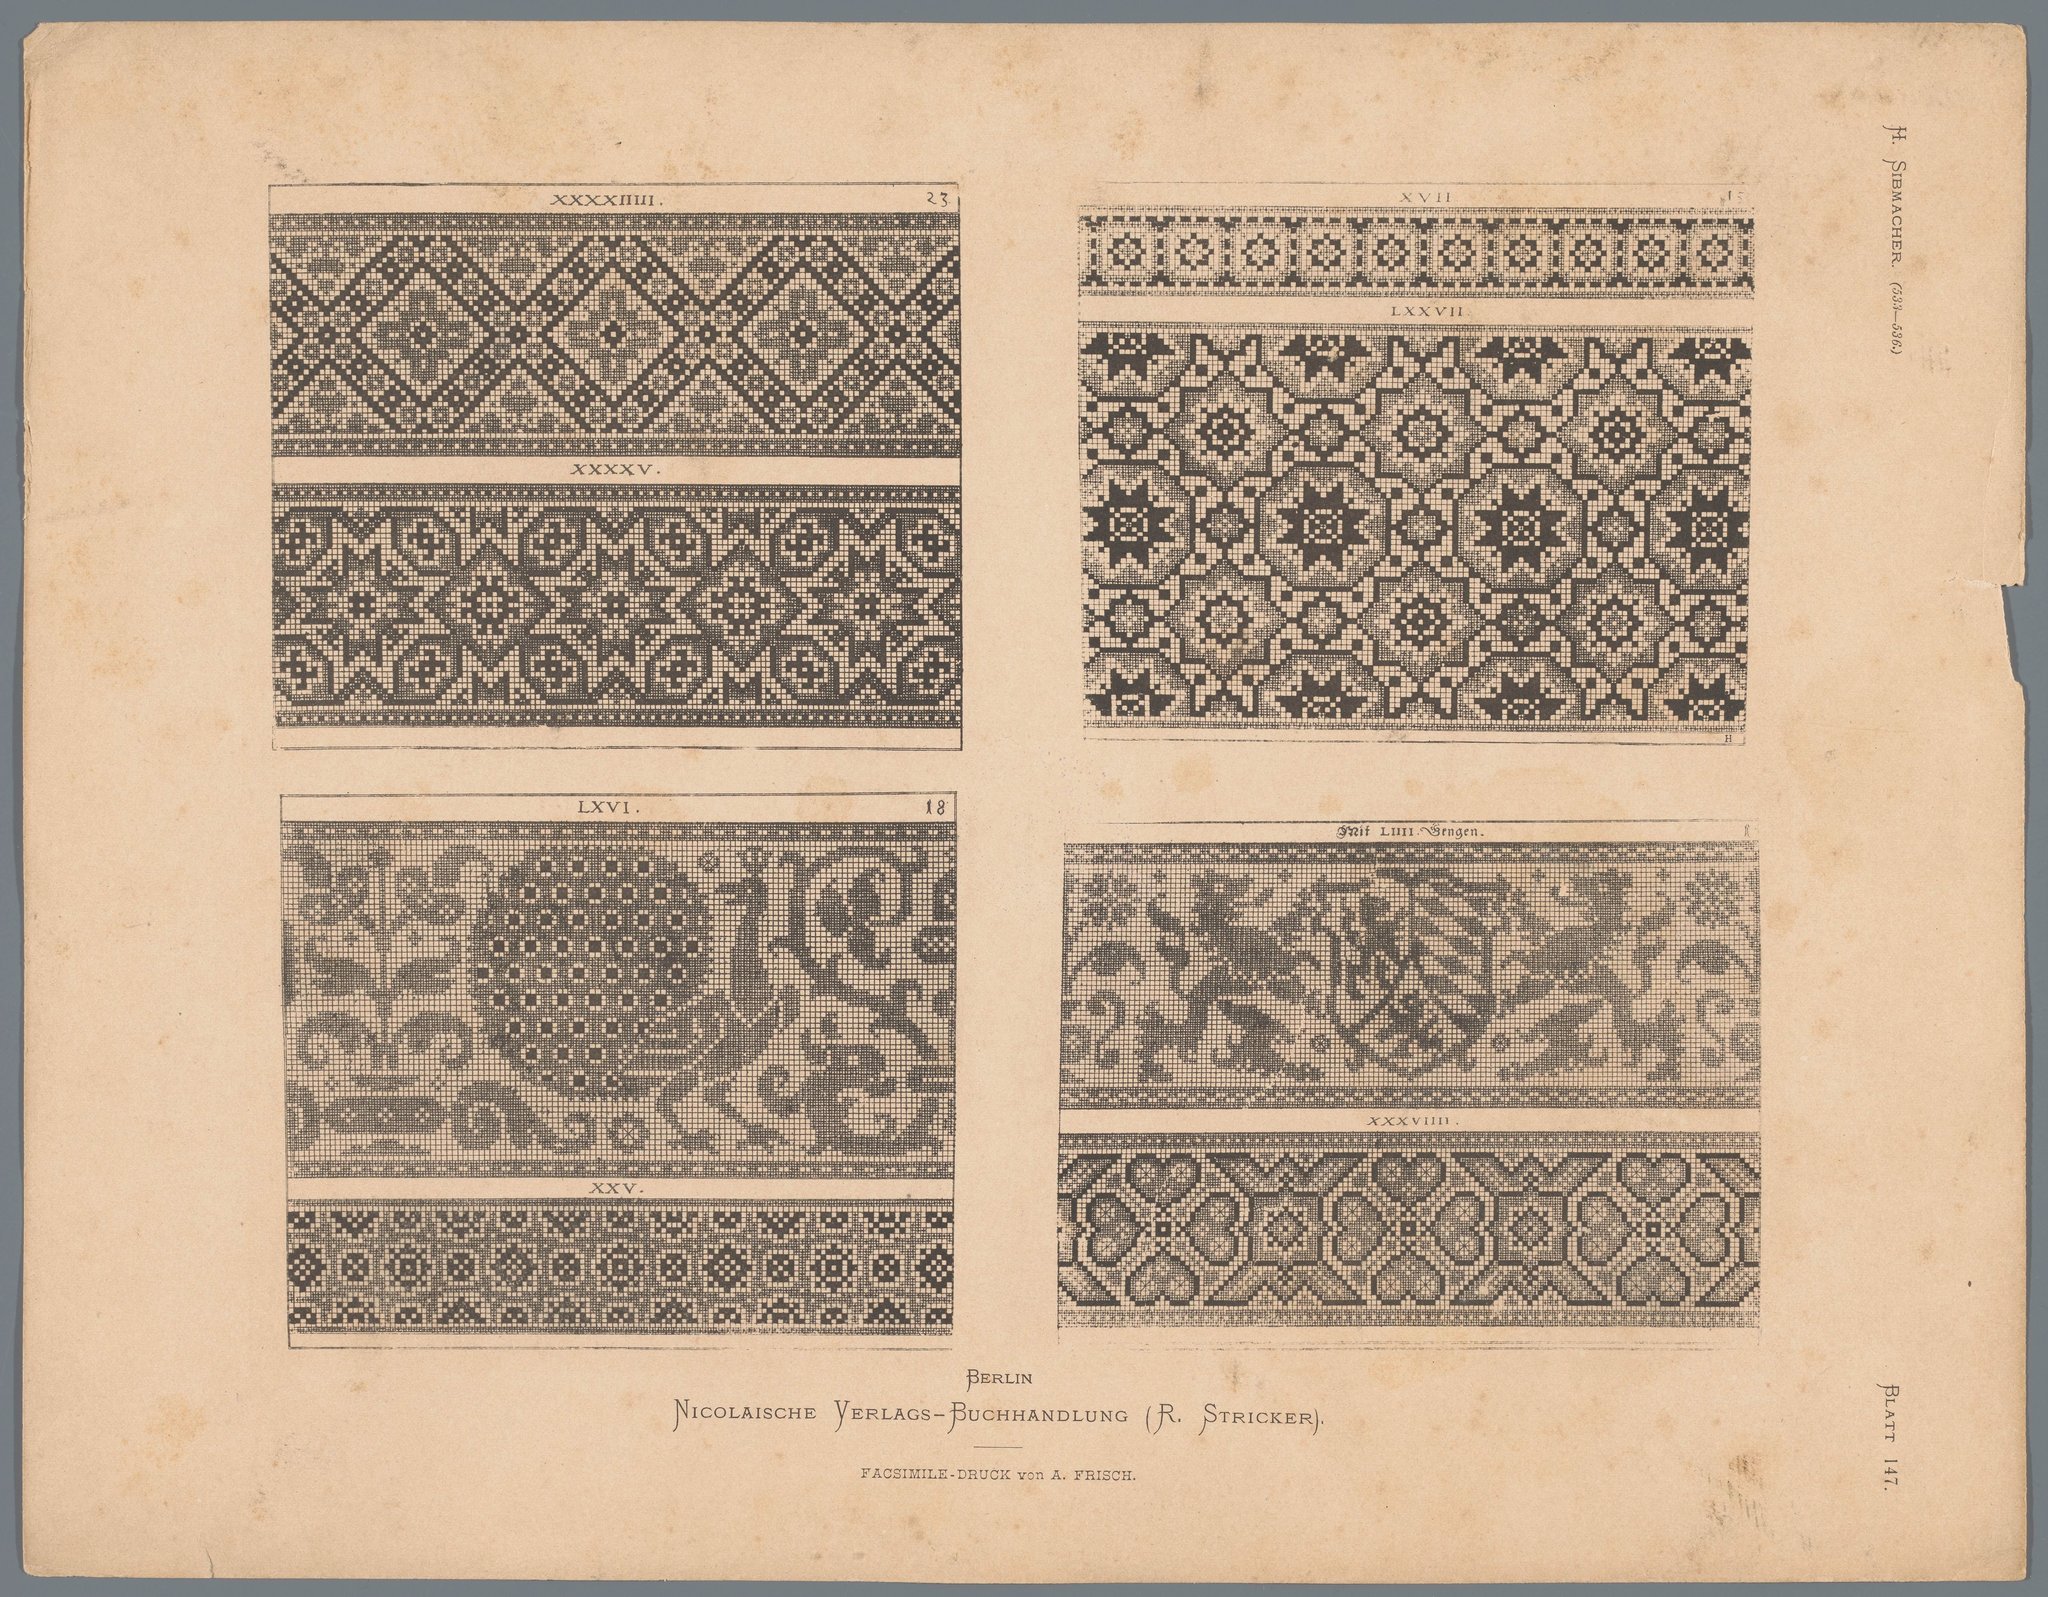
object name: photograph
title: Vier patronen voor borduurwerk door Johann Siebmacher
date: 1875-1900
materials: paper, ink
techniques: photograph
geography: europe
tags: embroidery (ornamentation), europe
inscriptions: inscription: ‘Blatt 147.’, collector's mark: Lugt 3937, name: ‘H. Sibmacher (533-536)’